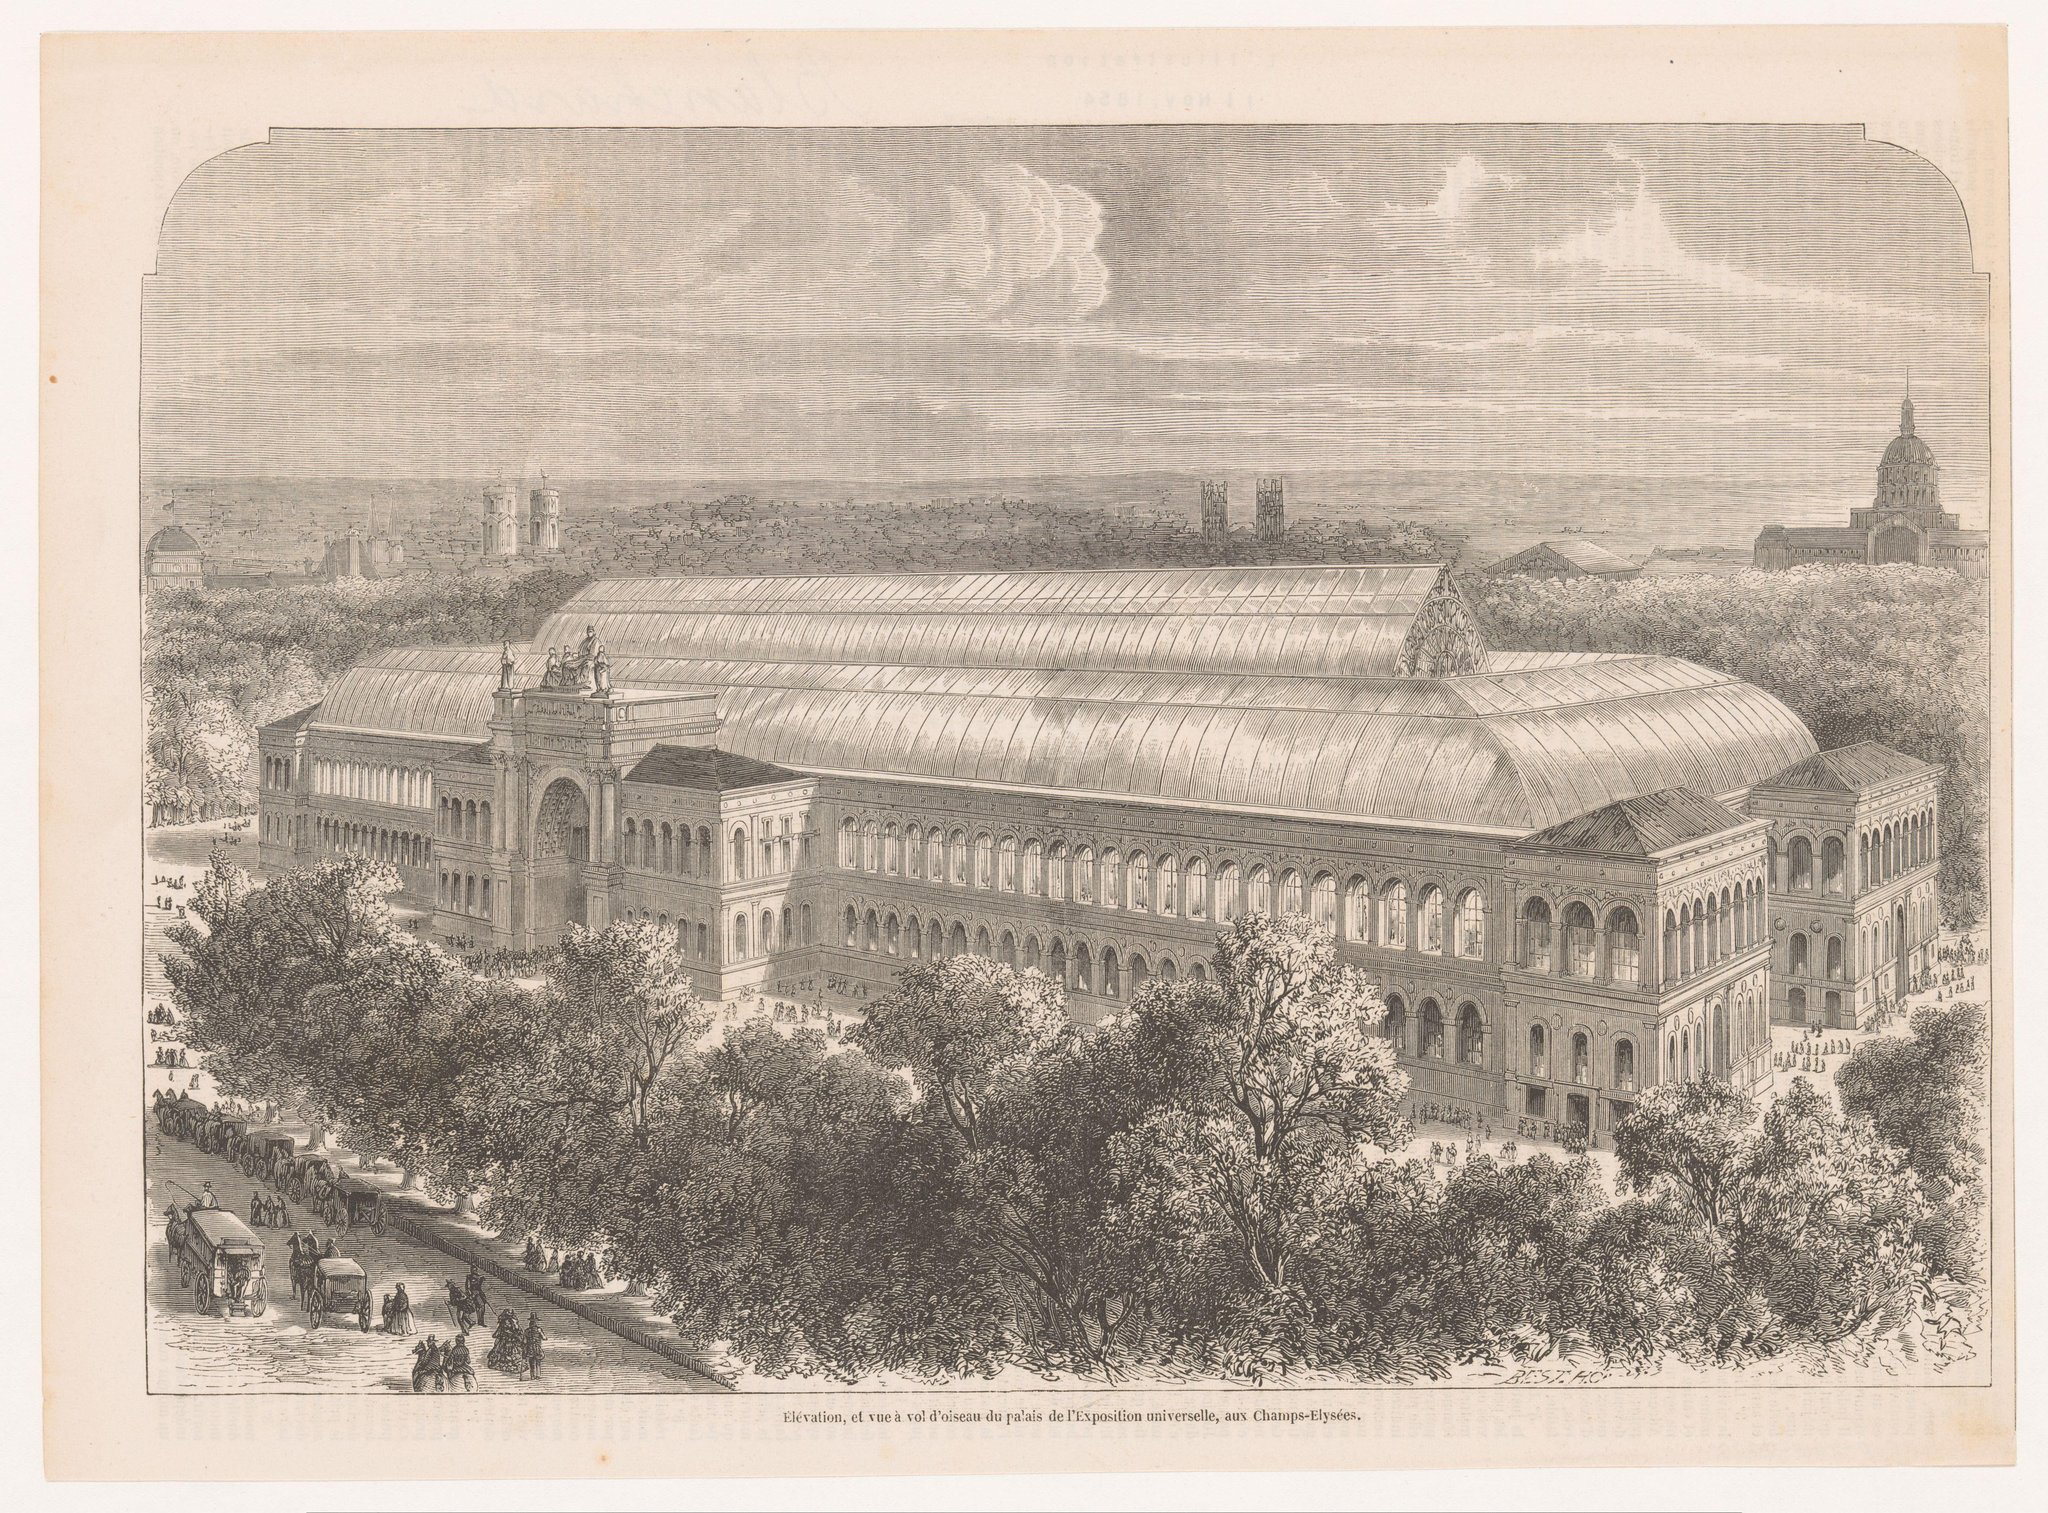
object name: print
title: Élévation, et vue a vol d'oiseau du palais de l'Exposition universelle, aux Champs-Elysées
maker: jacques-julien dubochet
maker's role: publisher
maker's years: 1798-1868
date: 1854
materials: paper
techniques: letterpress printing, engraving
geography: paris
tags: world fair, world exhibition, paris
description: Prent uit: L'Illustration, vol. 24, nr. 611, 11 november 1854, p. 328.